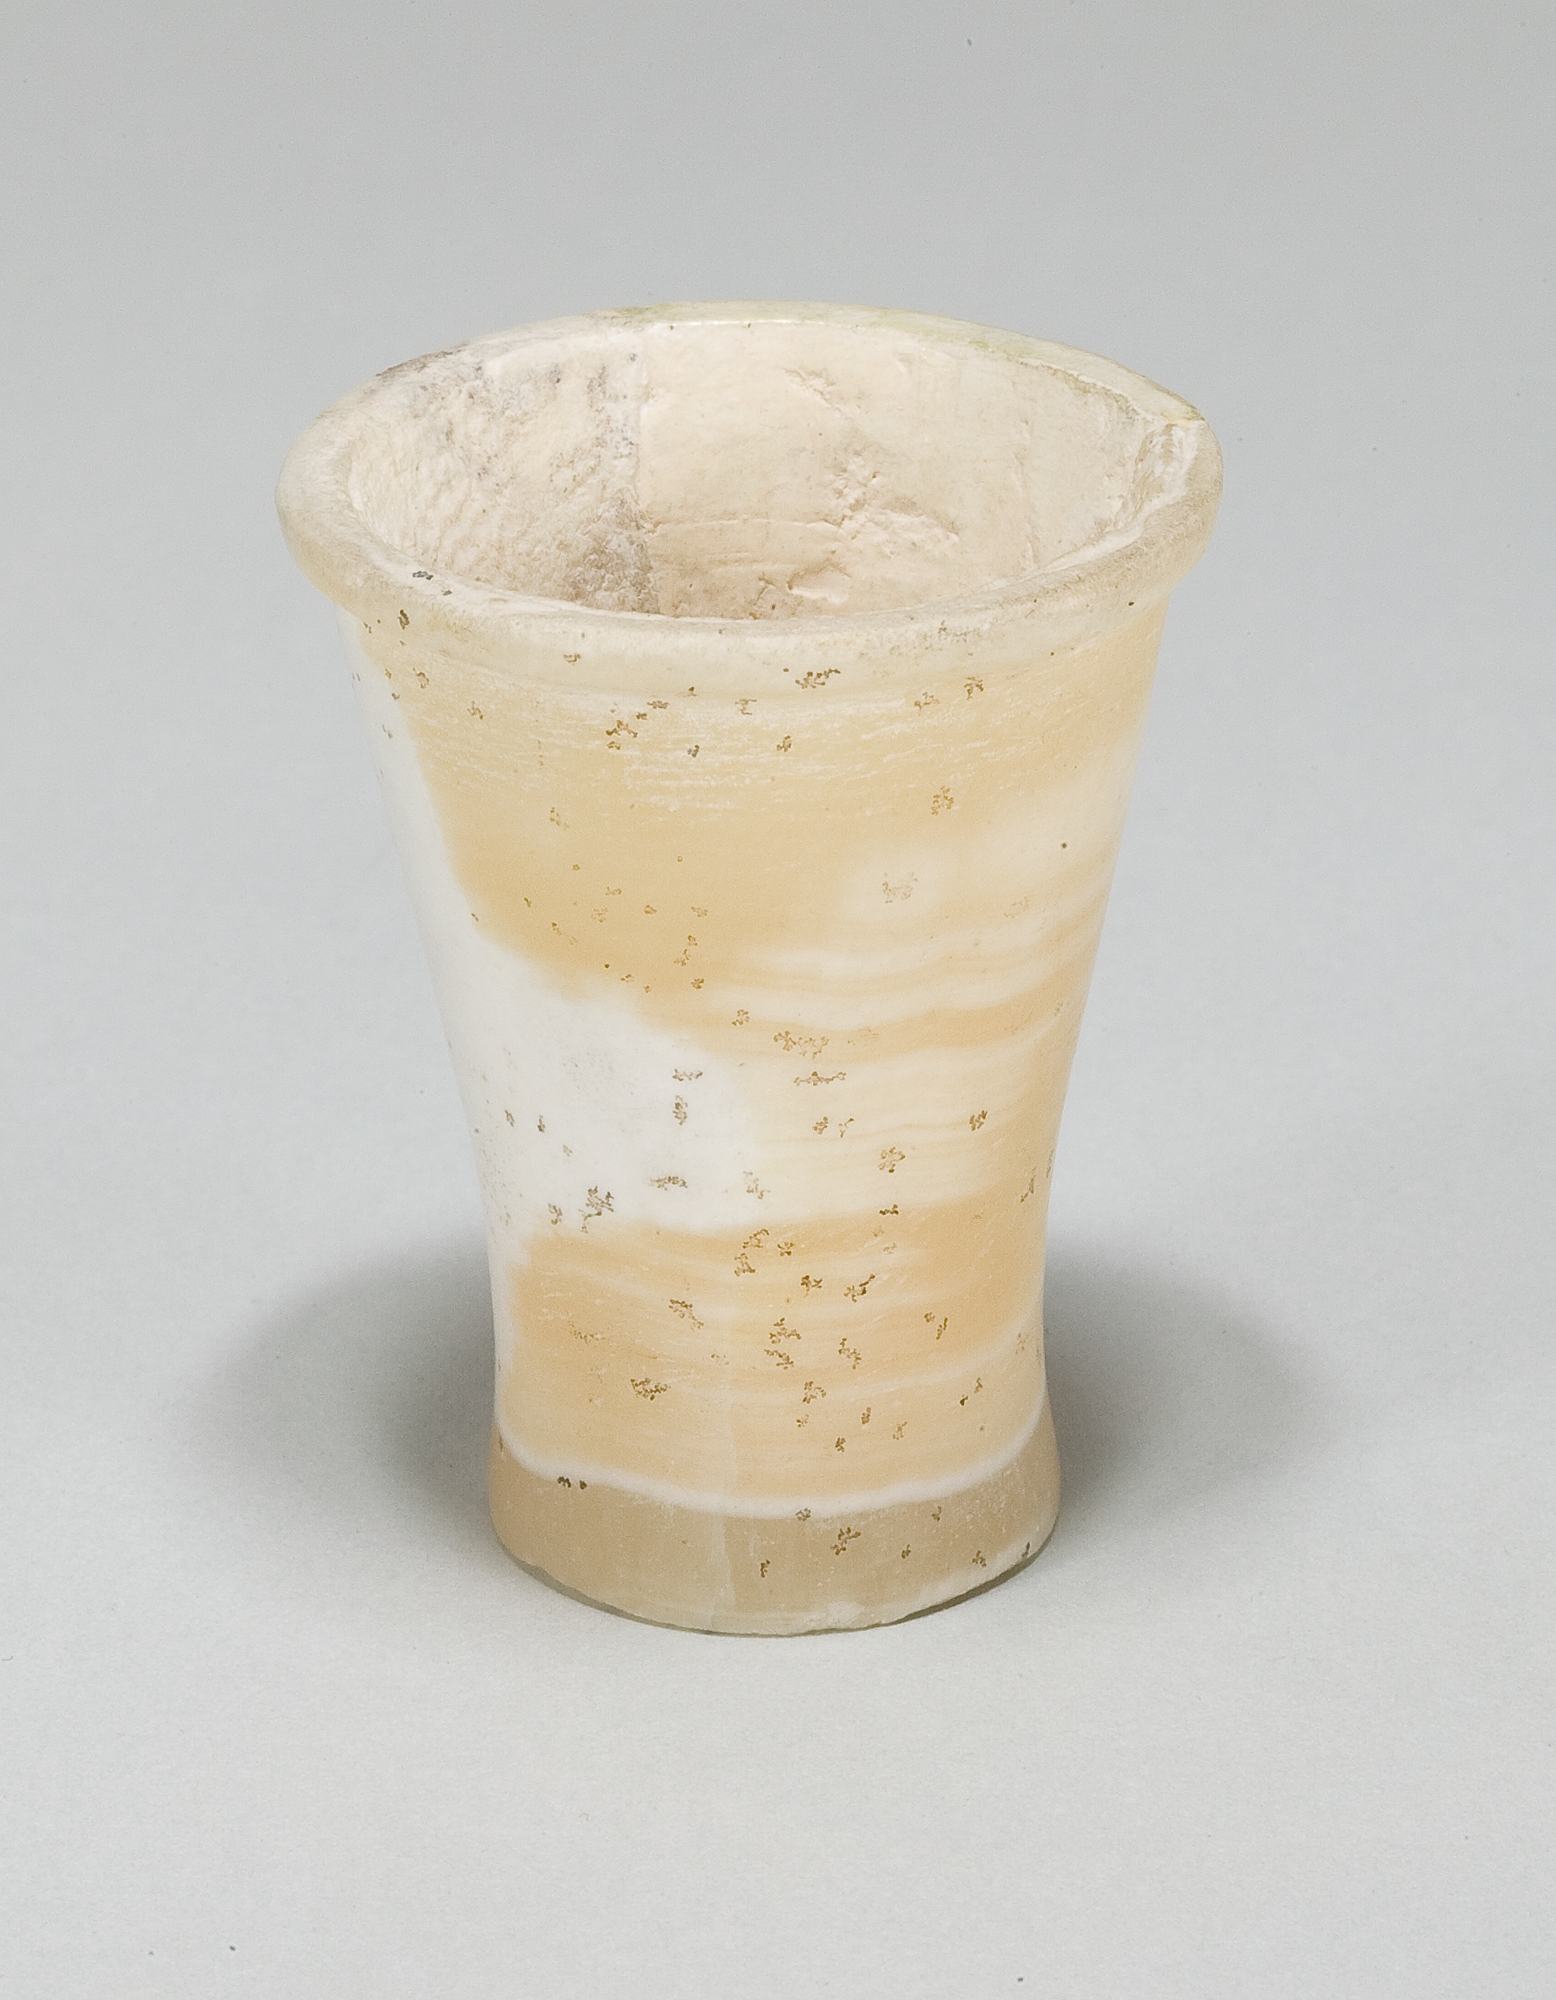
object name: miniature ointment jar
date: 1850-1775 BCE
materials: stone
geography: egypt